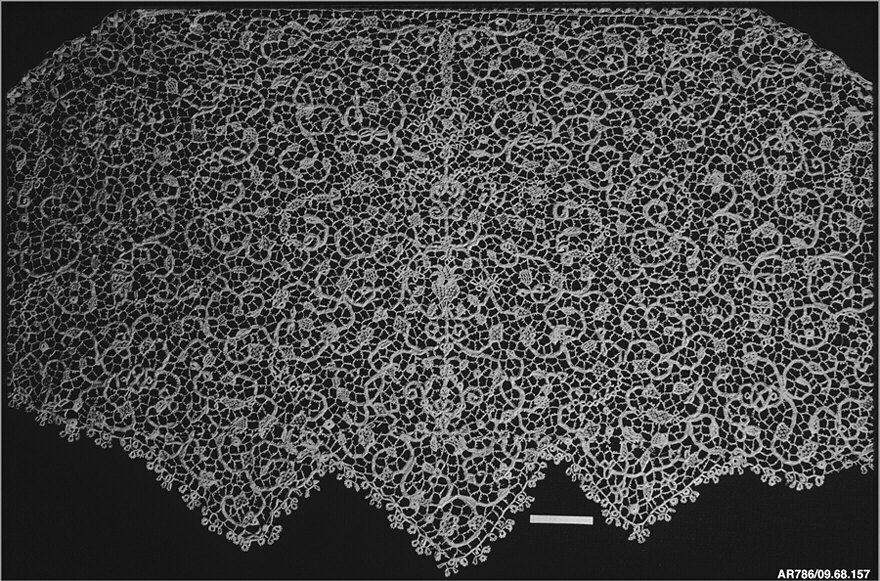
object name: rabat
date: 1801-1900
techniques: lace